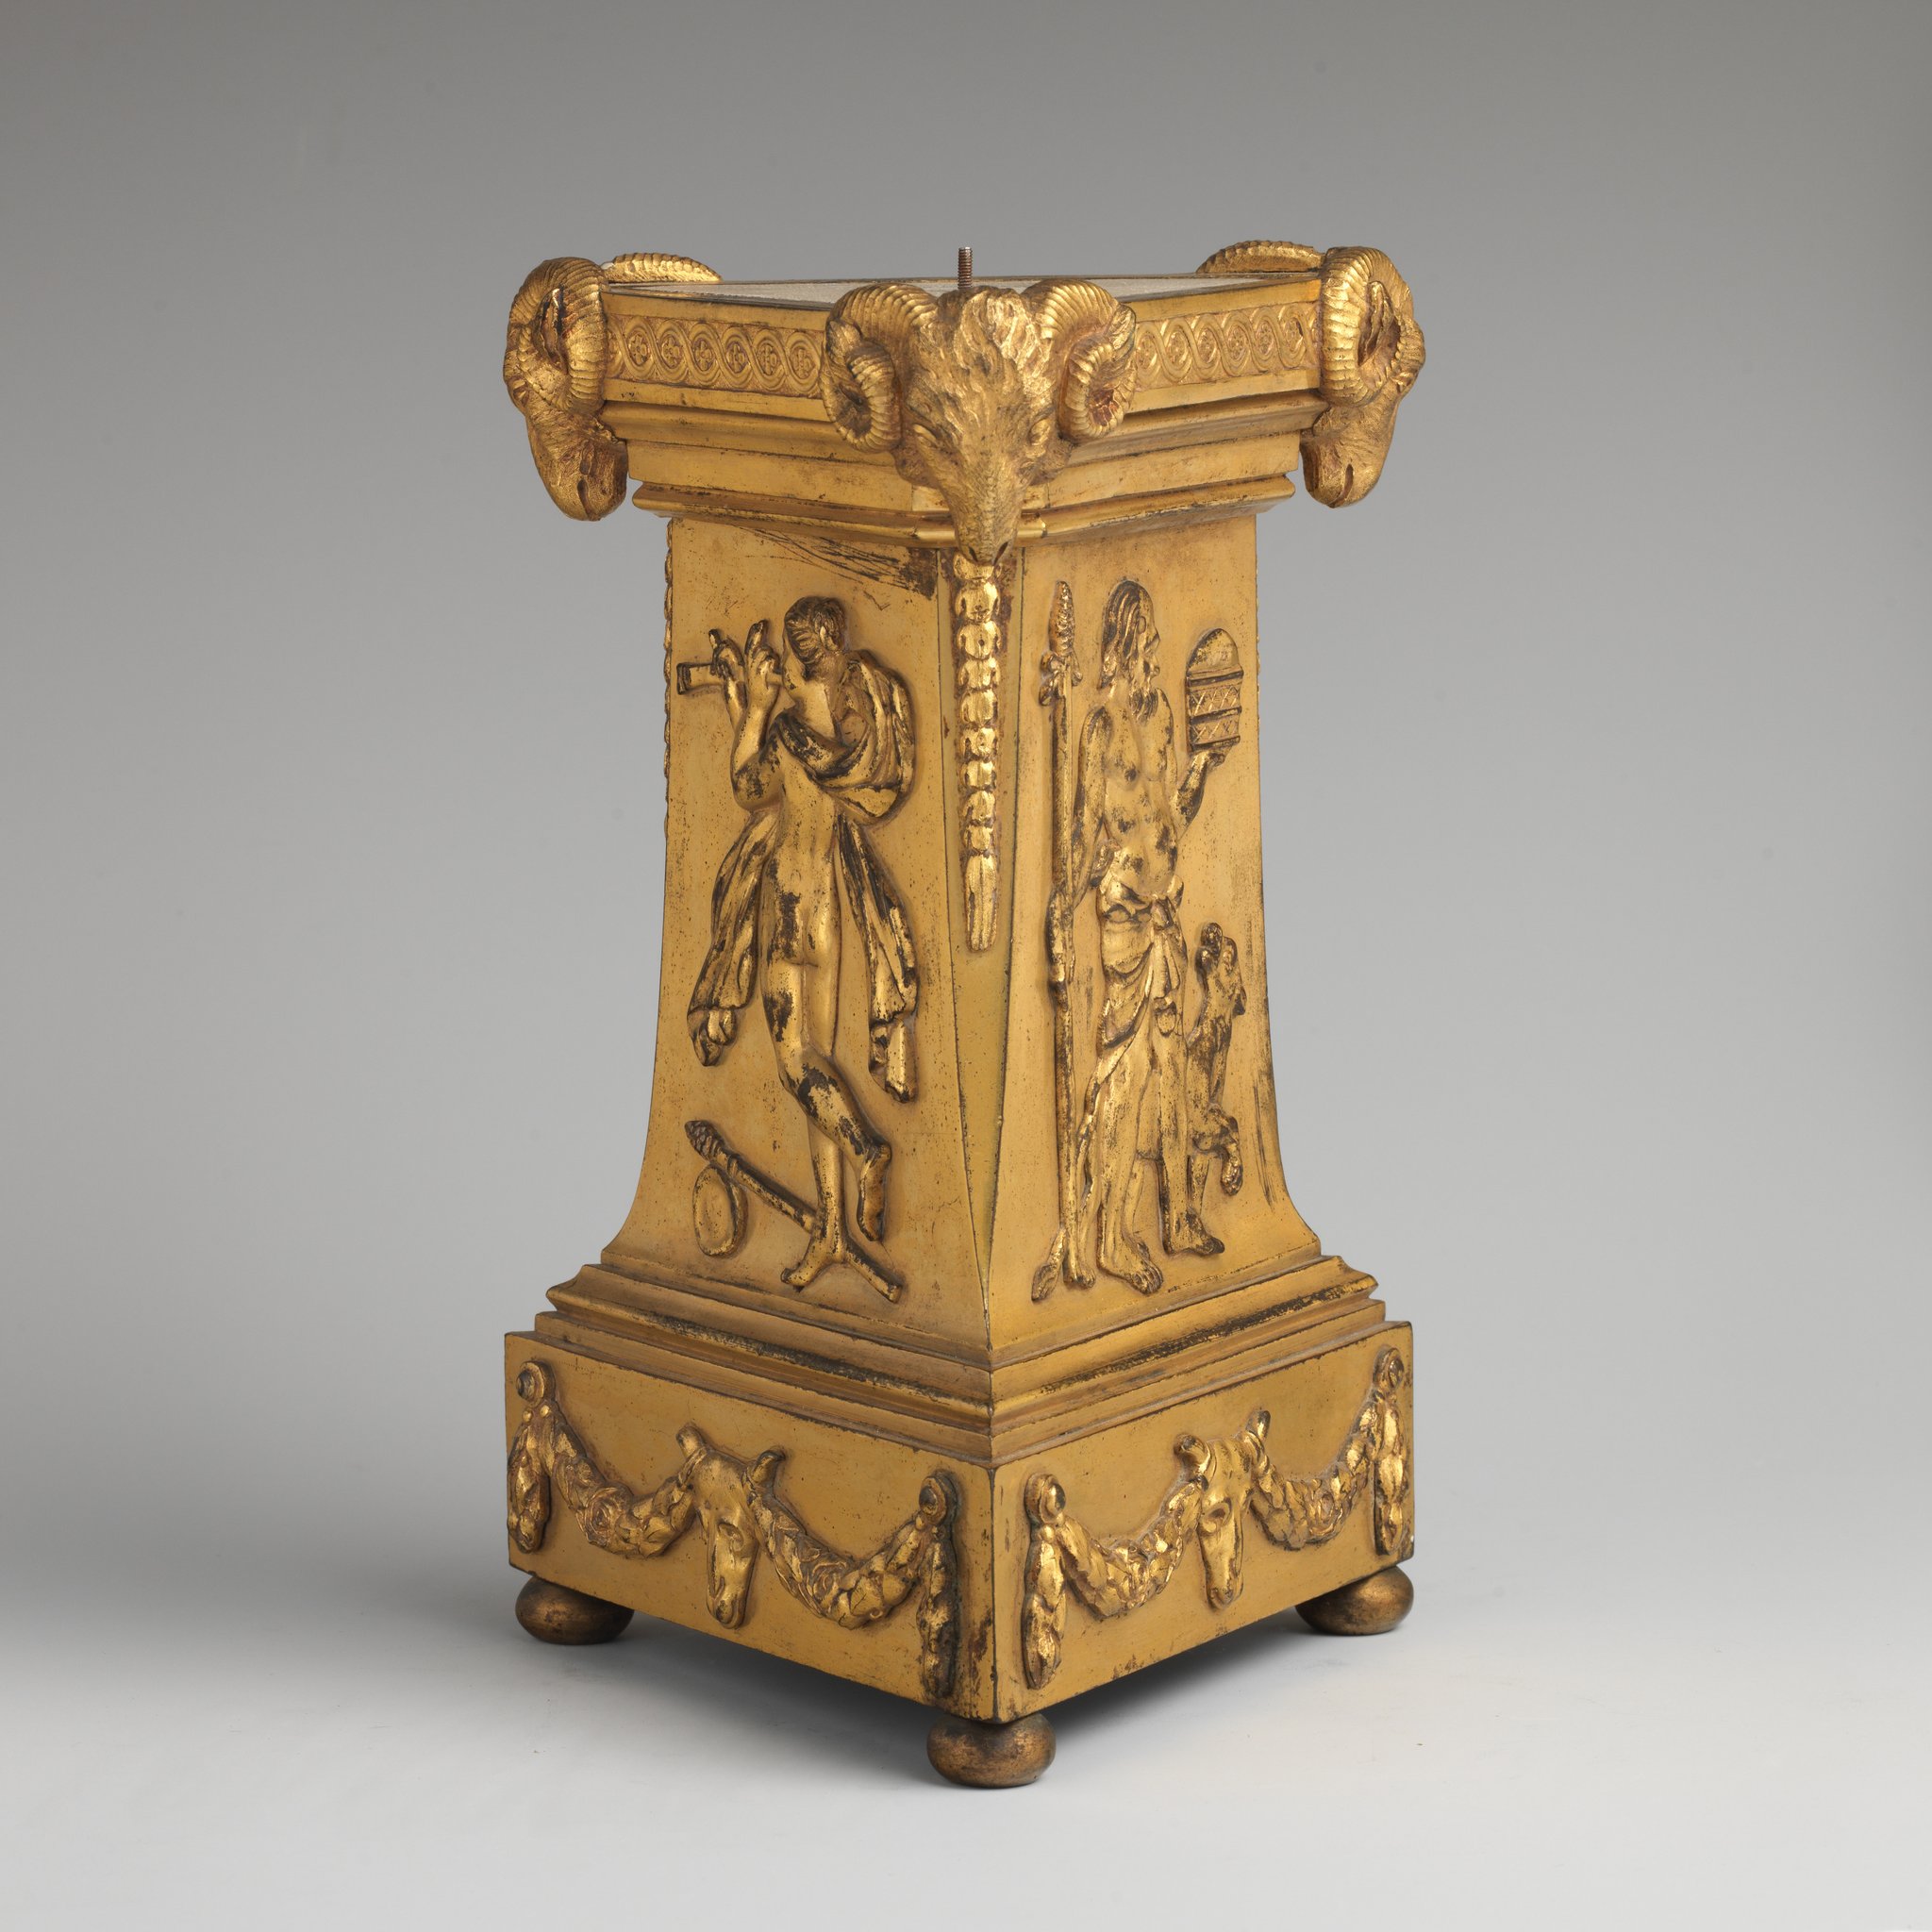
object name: pedestal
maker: matthew boulton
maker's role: maker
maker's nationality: british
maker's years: 1728-1809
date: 1770-1780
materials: gilt bronze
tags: musical instruments,animals,men,women